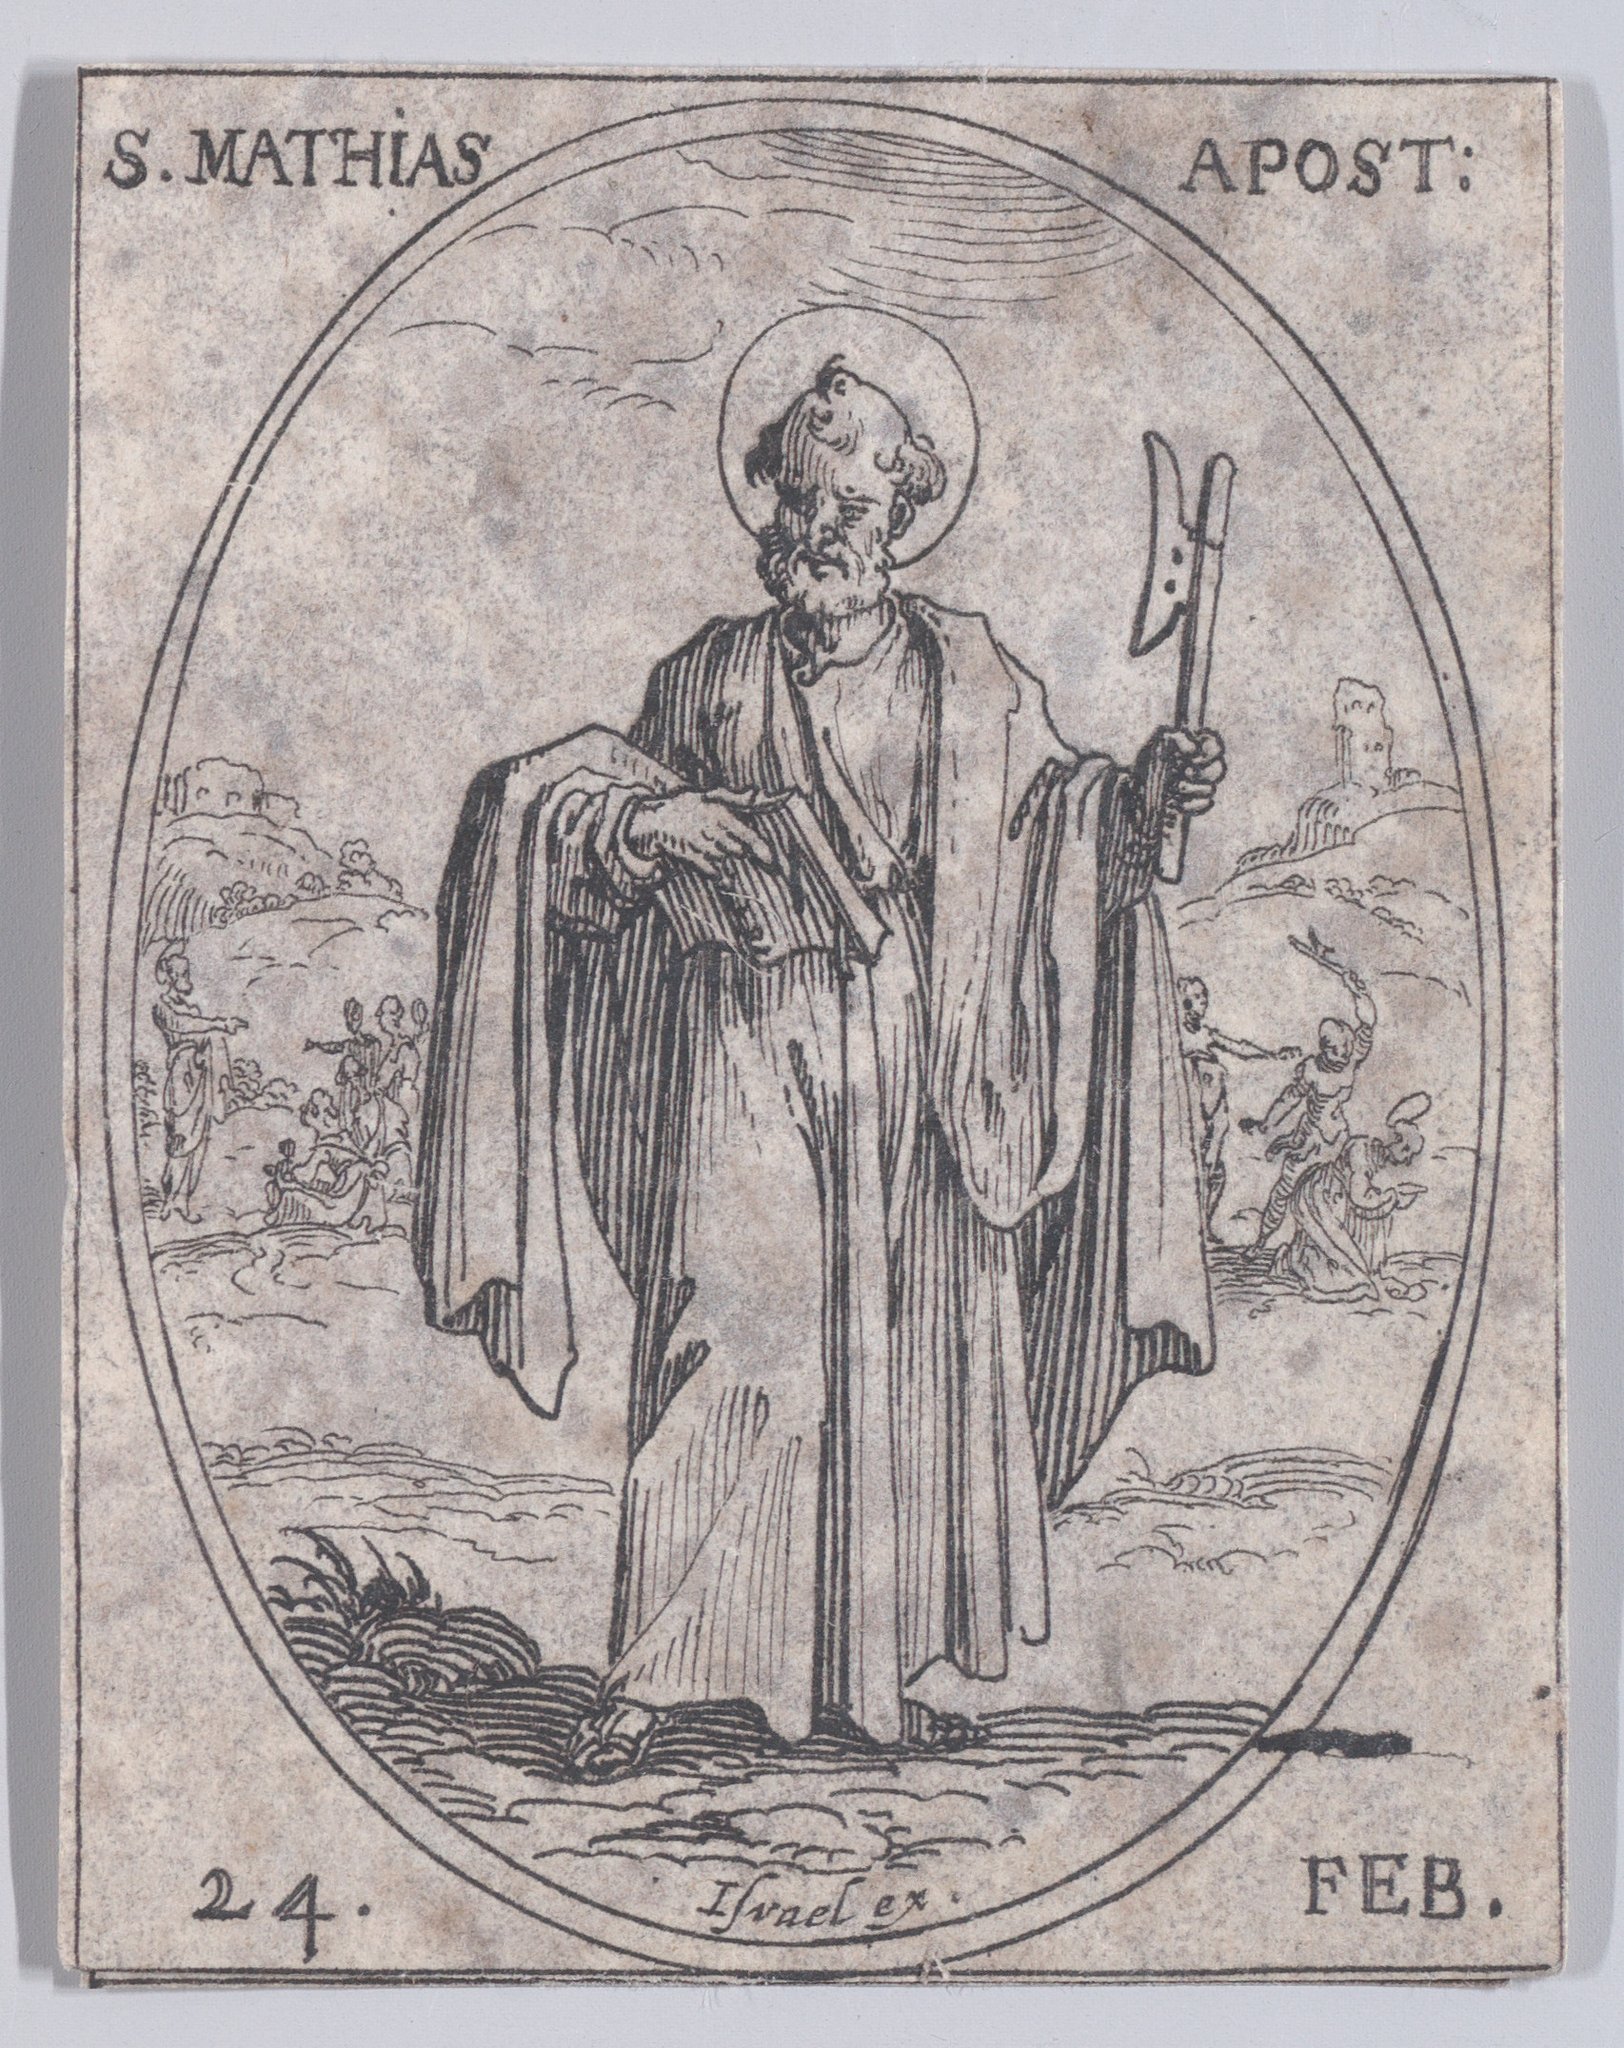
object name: print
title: S. Mathias, apôtre (St. Matthew, Apostle), February 24th, from "Les Images De Tous Les Saincts et Saintes de L'Année" (Images of All of the Saints and Religious Events of the Year)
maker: jacques callot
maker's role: artist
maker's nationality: french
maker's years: 1592-1635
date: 1636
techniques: etching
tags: men,saints